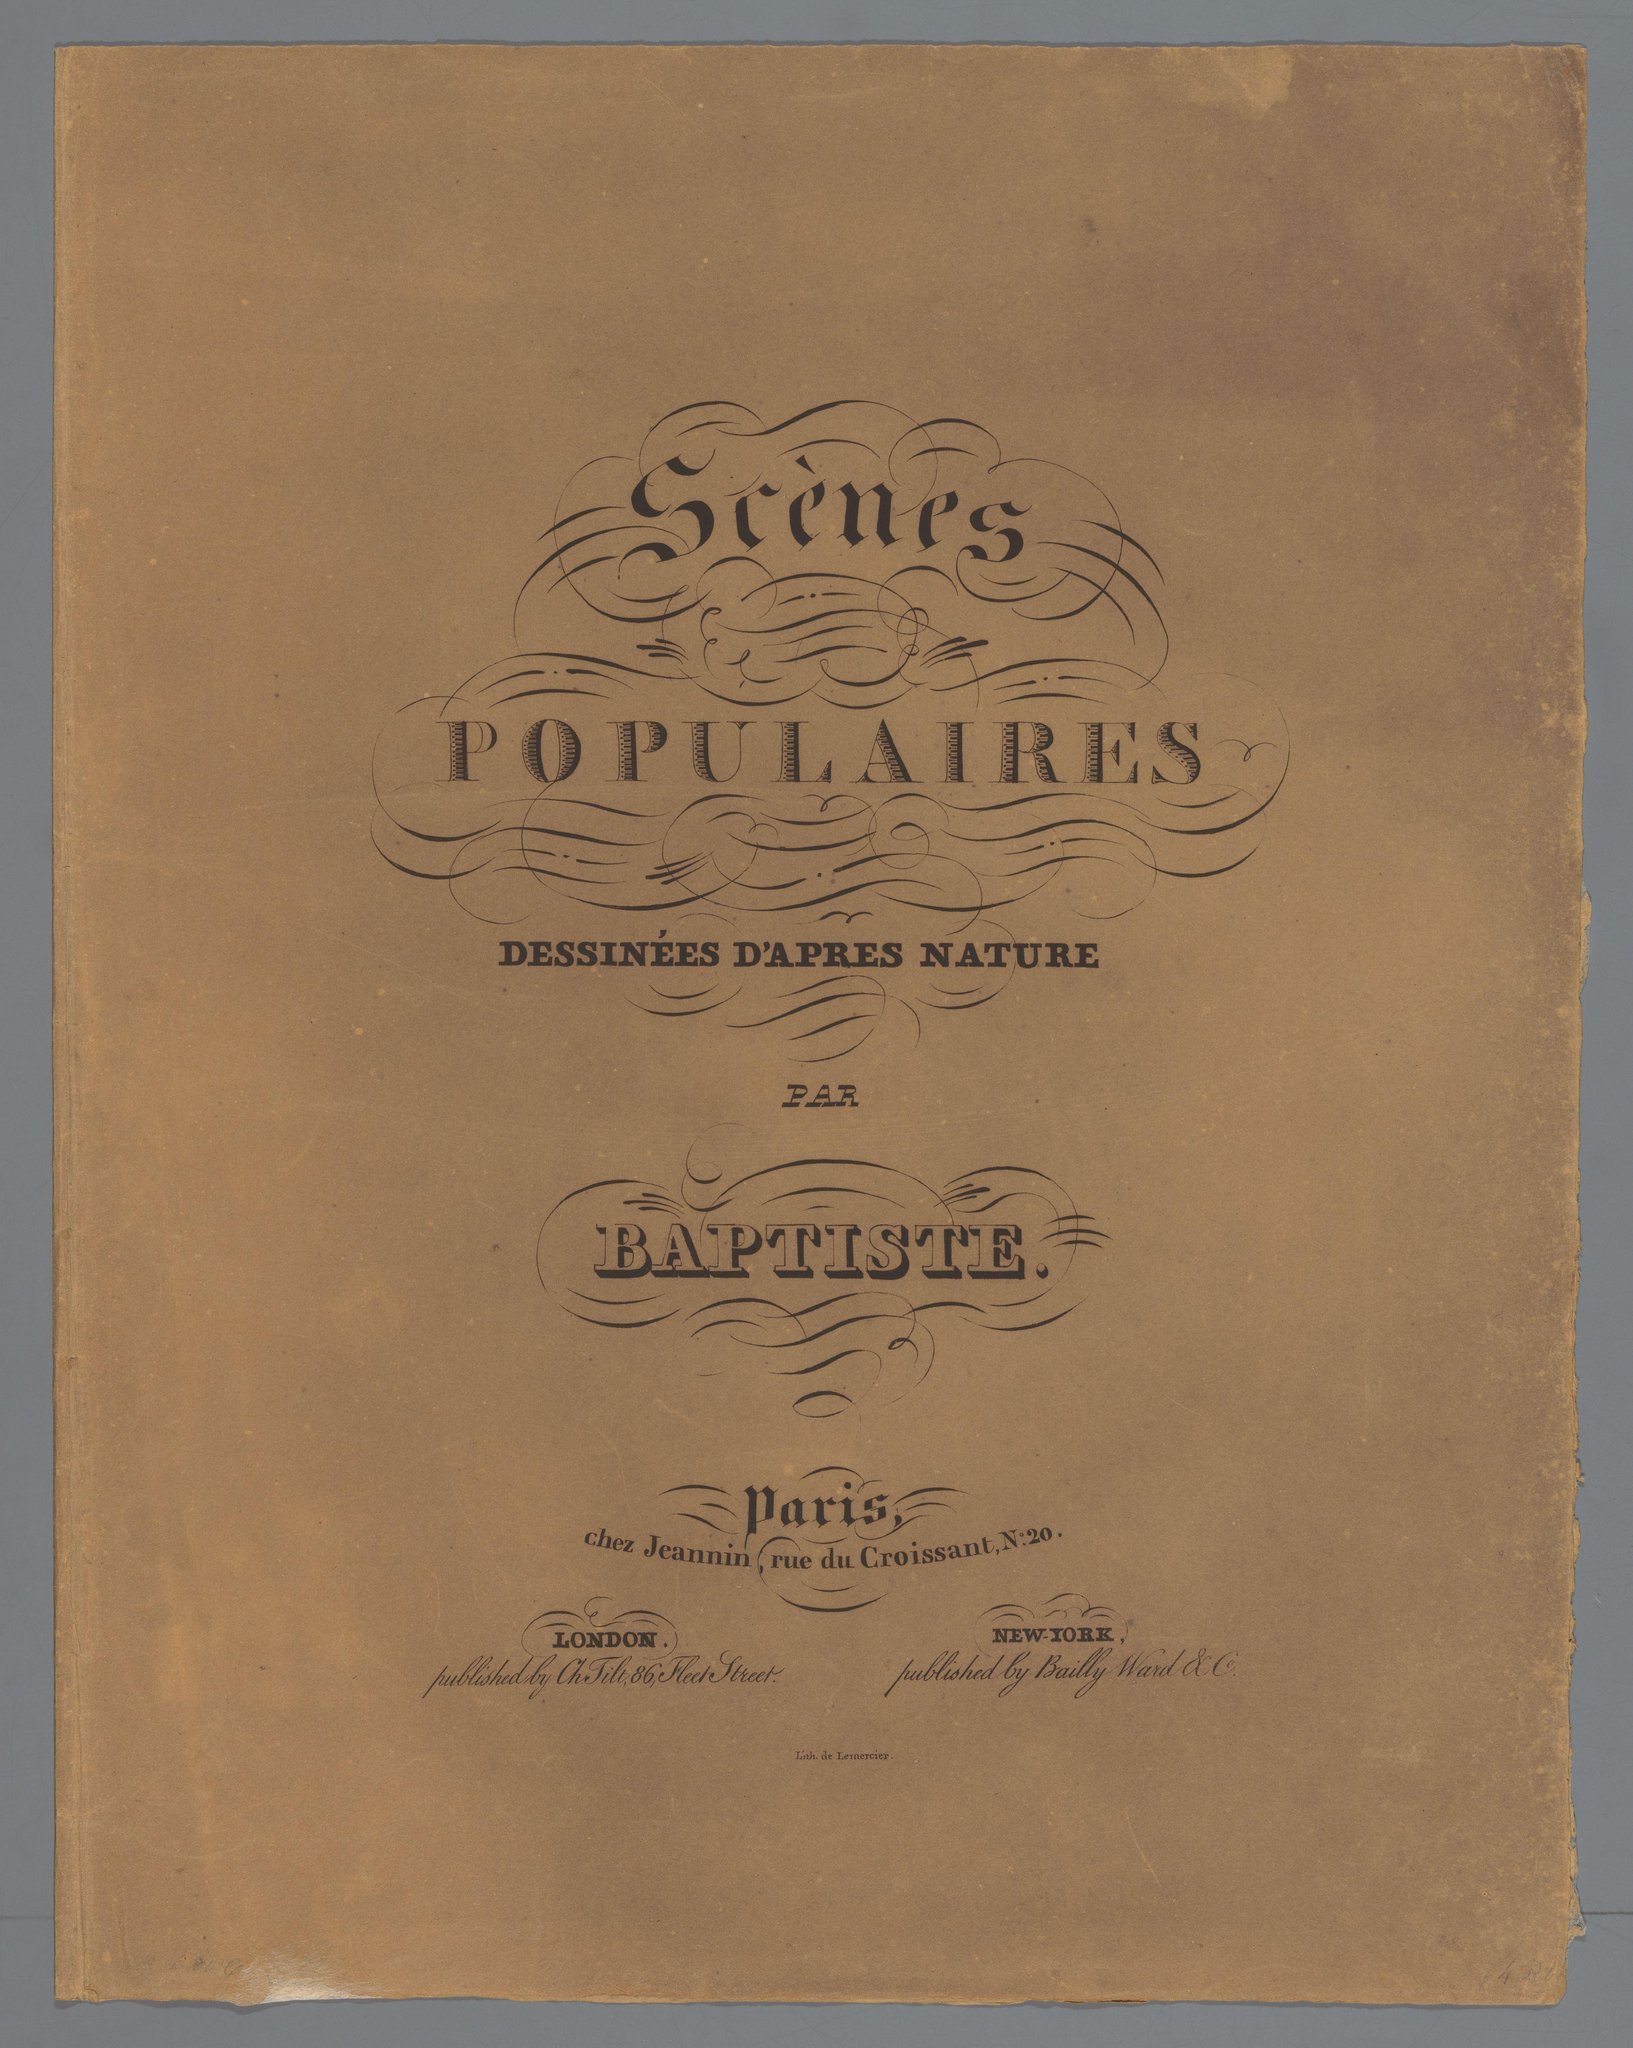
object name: wrapper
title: Omslag voor: Taferelen uit het dagelijks leven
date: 1833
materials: paper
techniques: lithograph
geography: london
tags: commoners, paris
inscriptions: collector's mark: Lugt 2228a